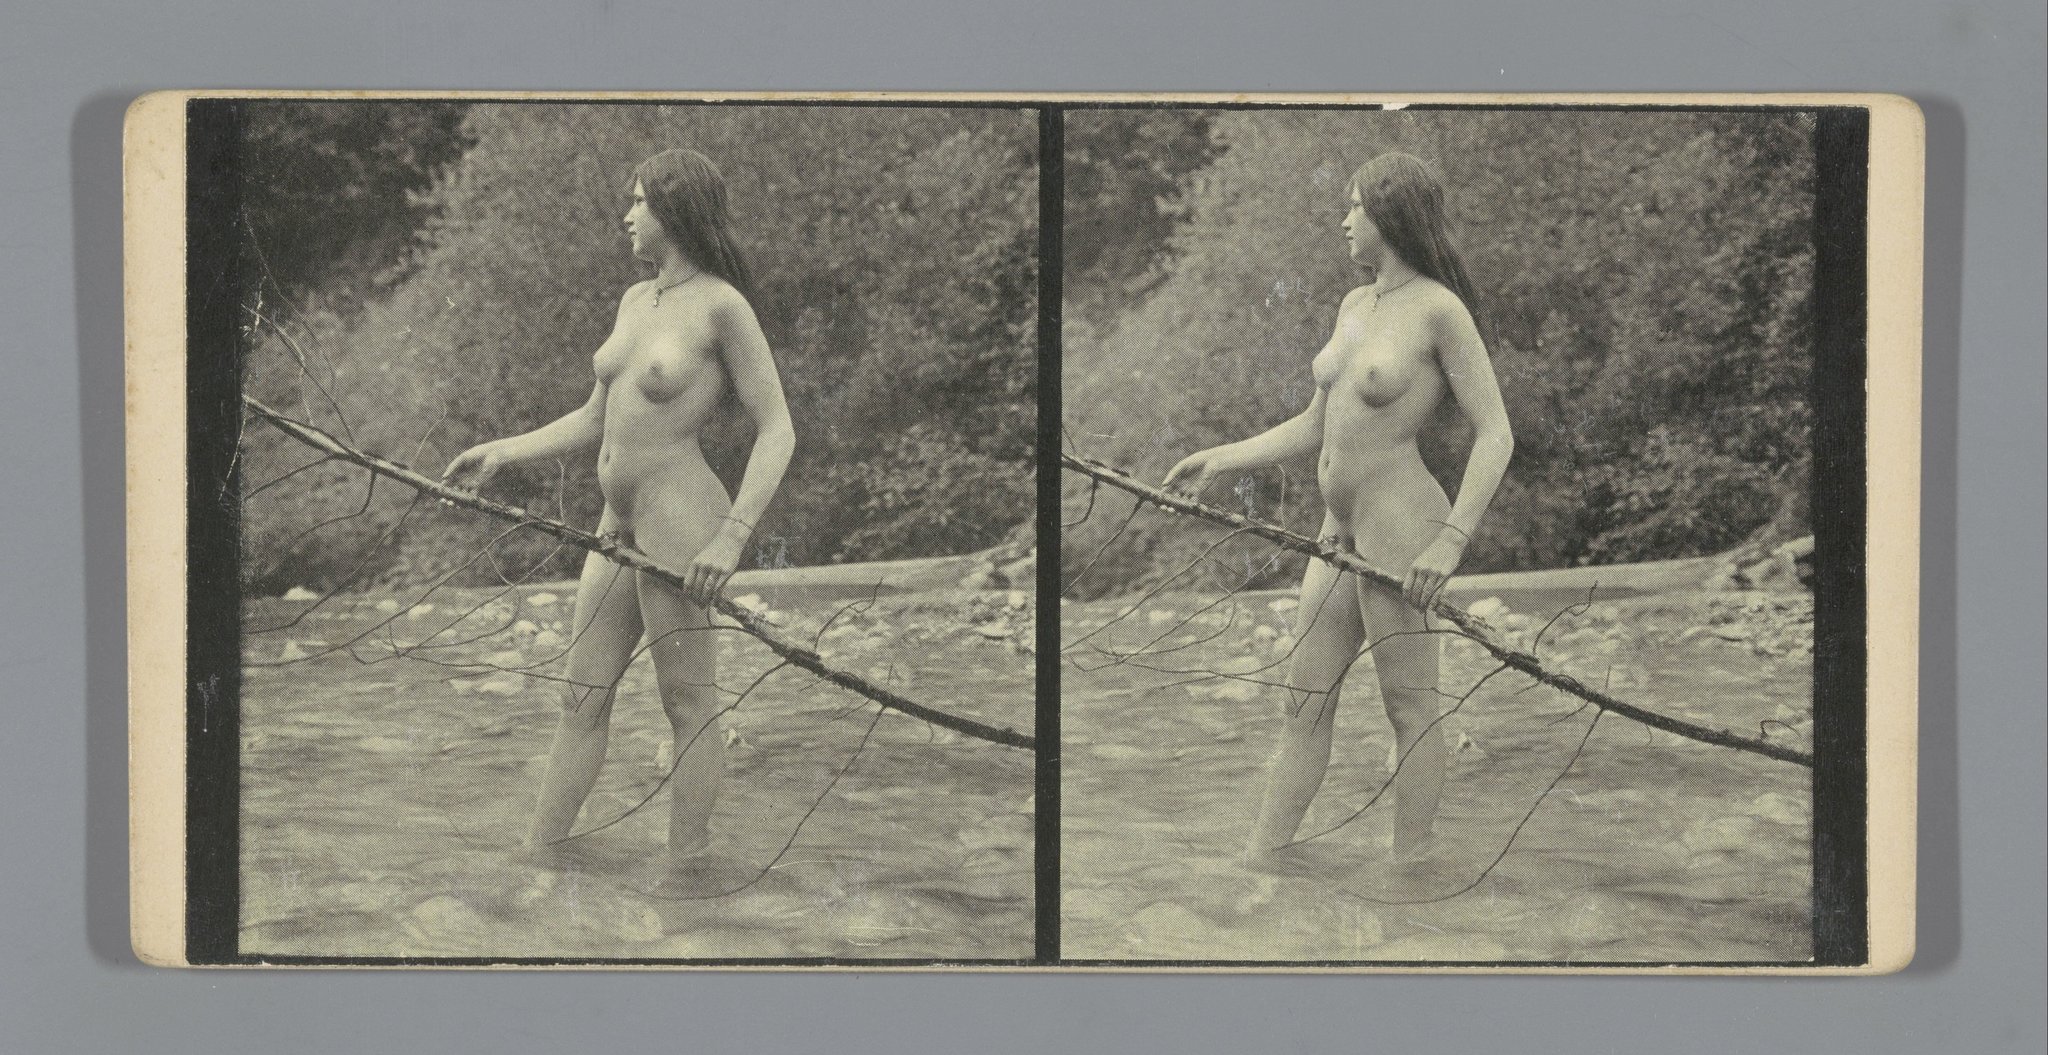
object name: stereograph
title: Portret van een naakte vrouw in een beek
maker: Anonymous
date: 1873-1910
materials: cardboard, paper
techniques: autotype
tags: woman (showing herself) undressed, quasi-nude, anonymous historical person portrayed